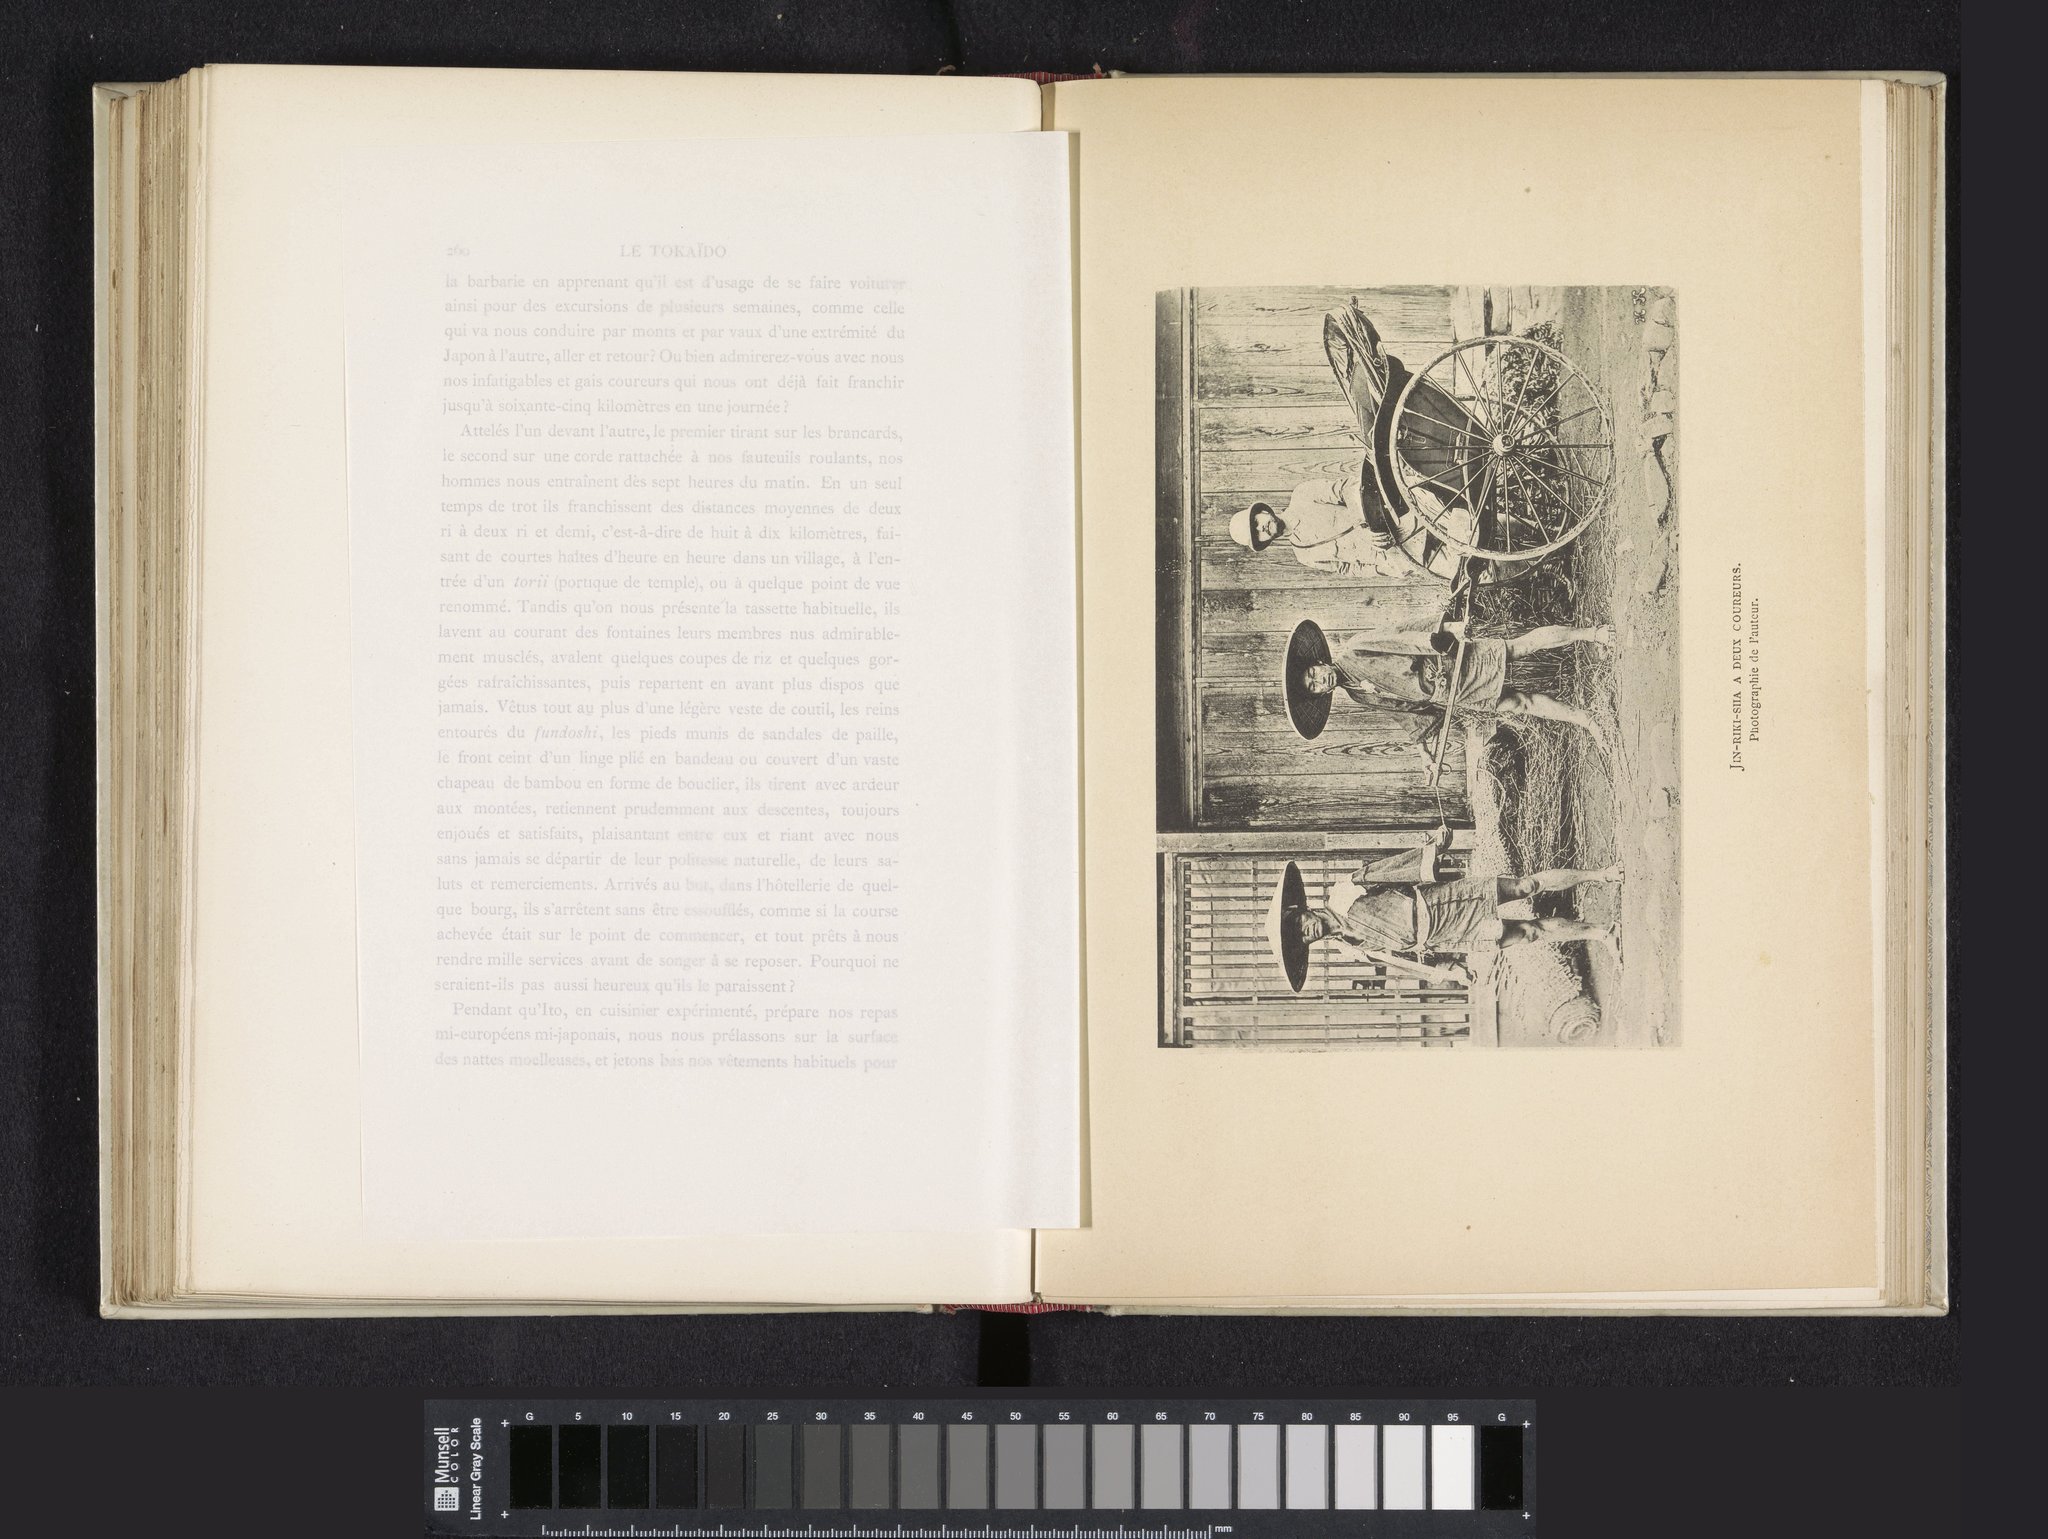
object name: page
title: Riksja met twee trekkers te Japan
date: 1882-1883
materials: paper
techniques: photograph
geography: tokaido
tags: rickshaw, adult man, façade (of house or building)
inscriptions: inscription: ‘Photographie de l'auteur.’, inscription: ‘H. K.’